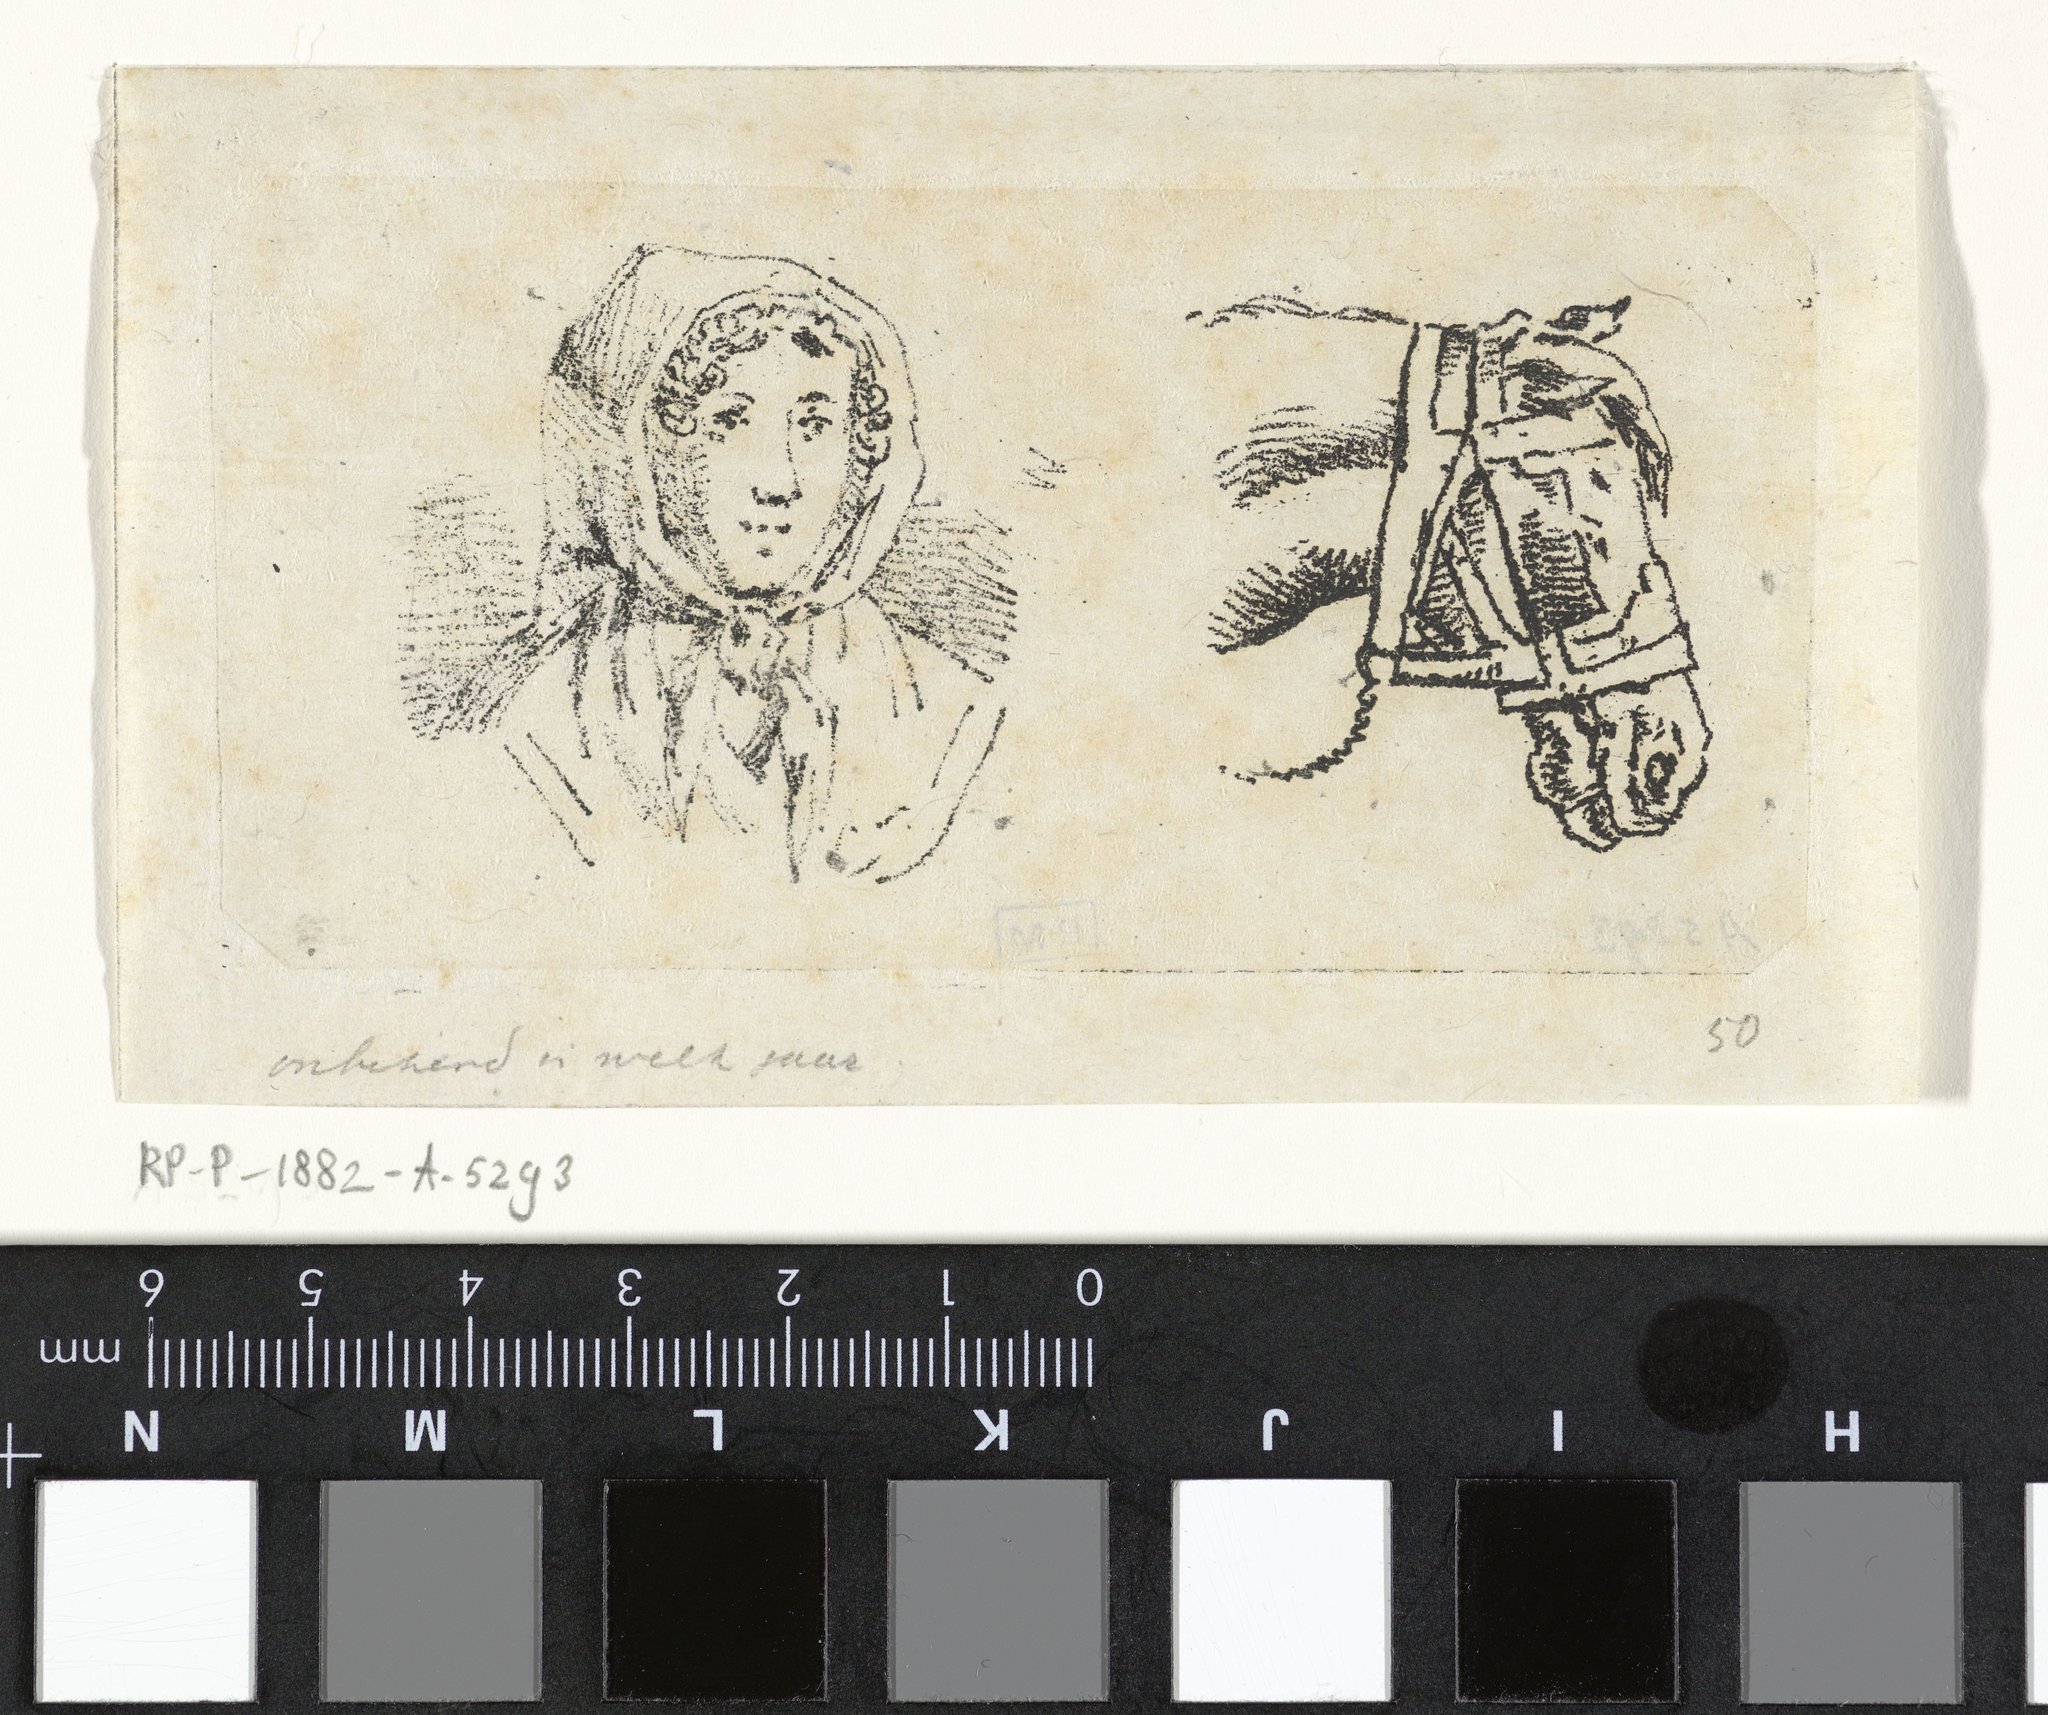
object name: print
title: Vrouw en een paard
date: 1803-1842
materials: paper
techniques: etching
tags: adolescent, young woman, maiden, boulder, stone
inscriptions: collector's mark: Lugt 2227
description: Buste van een vrouw met hoofddoek en een paardenhoofd naar rechts.